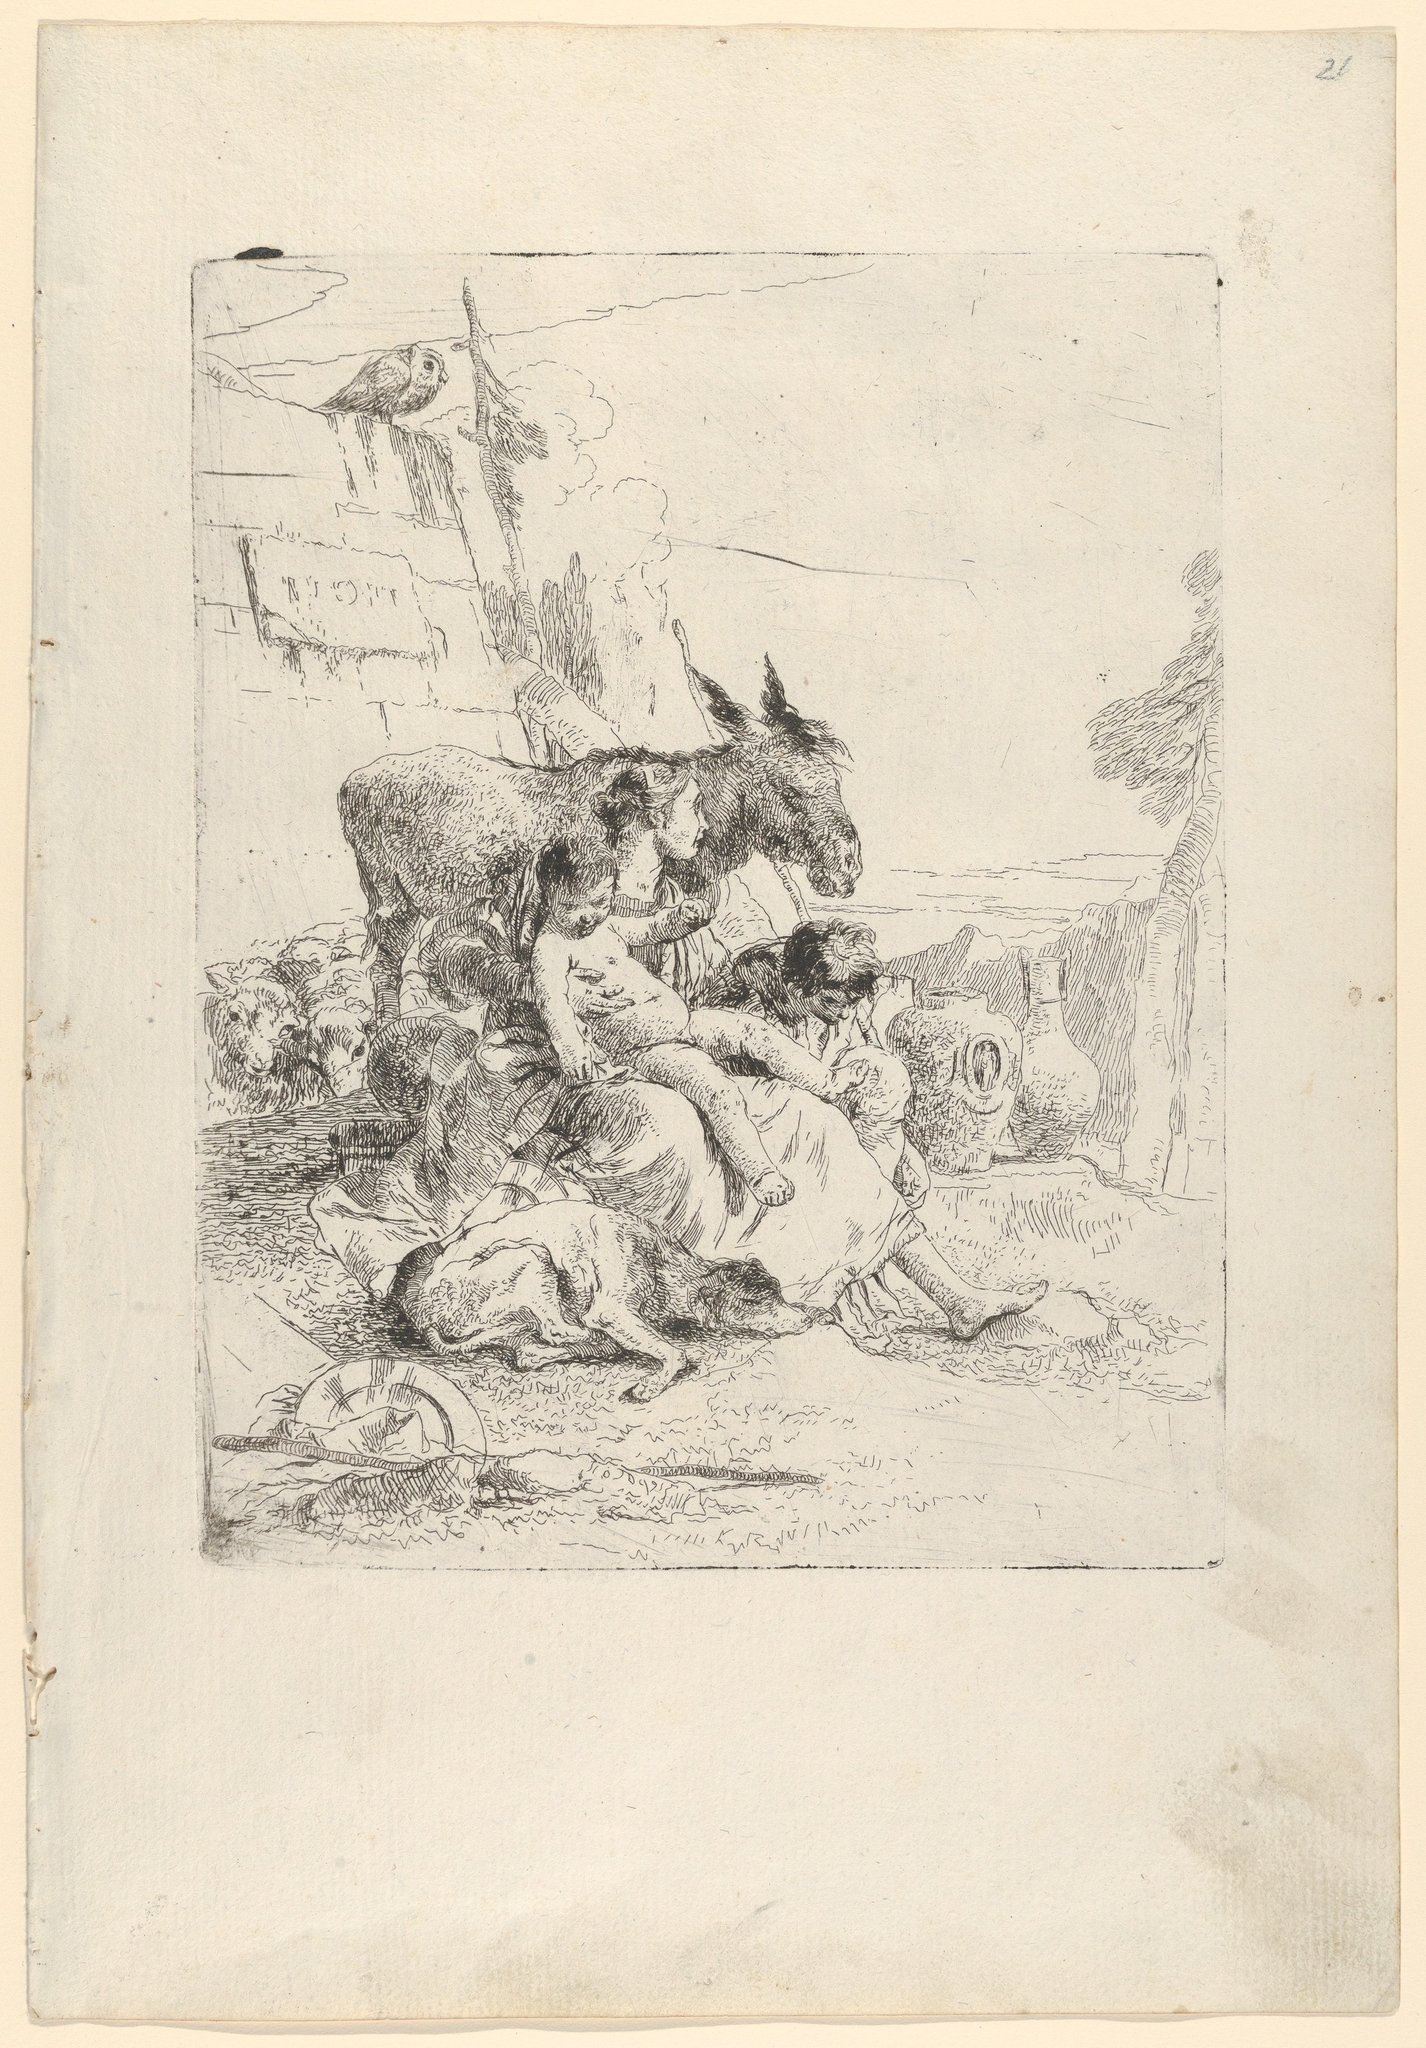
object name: print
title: A Mother with two Children, from the Scherzi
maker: giovanni battista tiepolo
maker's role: artist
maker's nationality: italian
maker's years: 1696-1770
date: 1740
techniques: etching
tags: children,mothers,donkeys